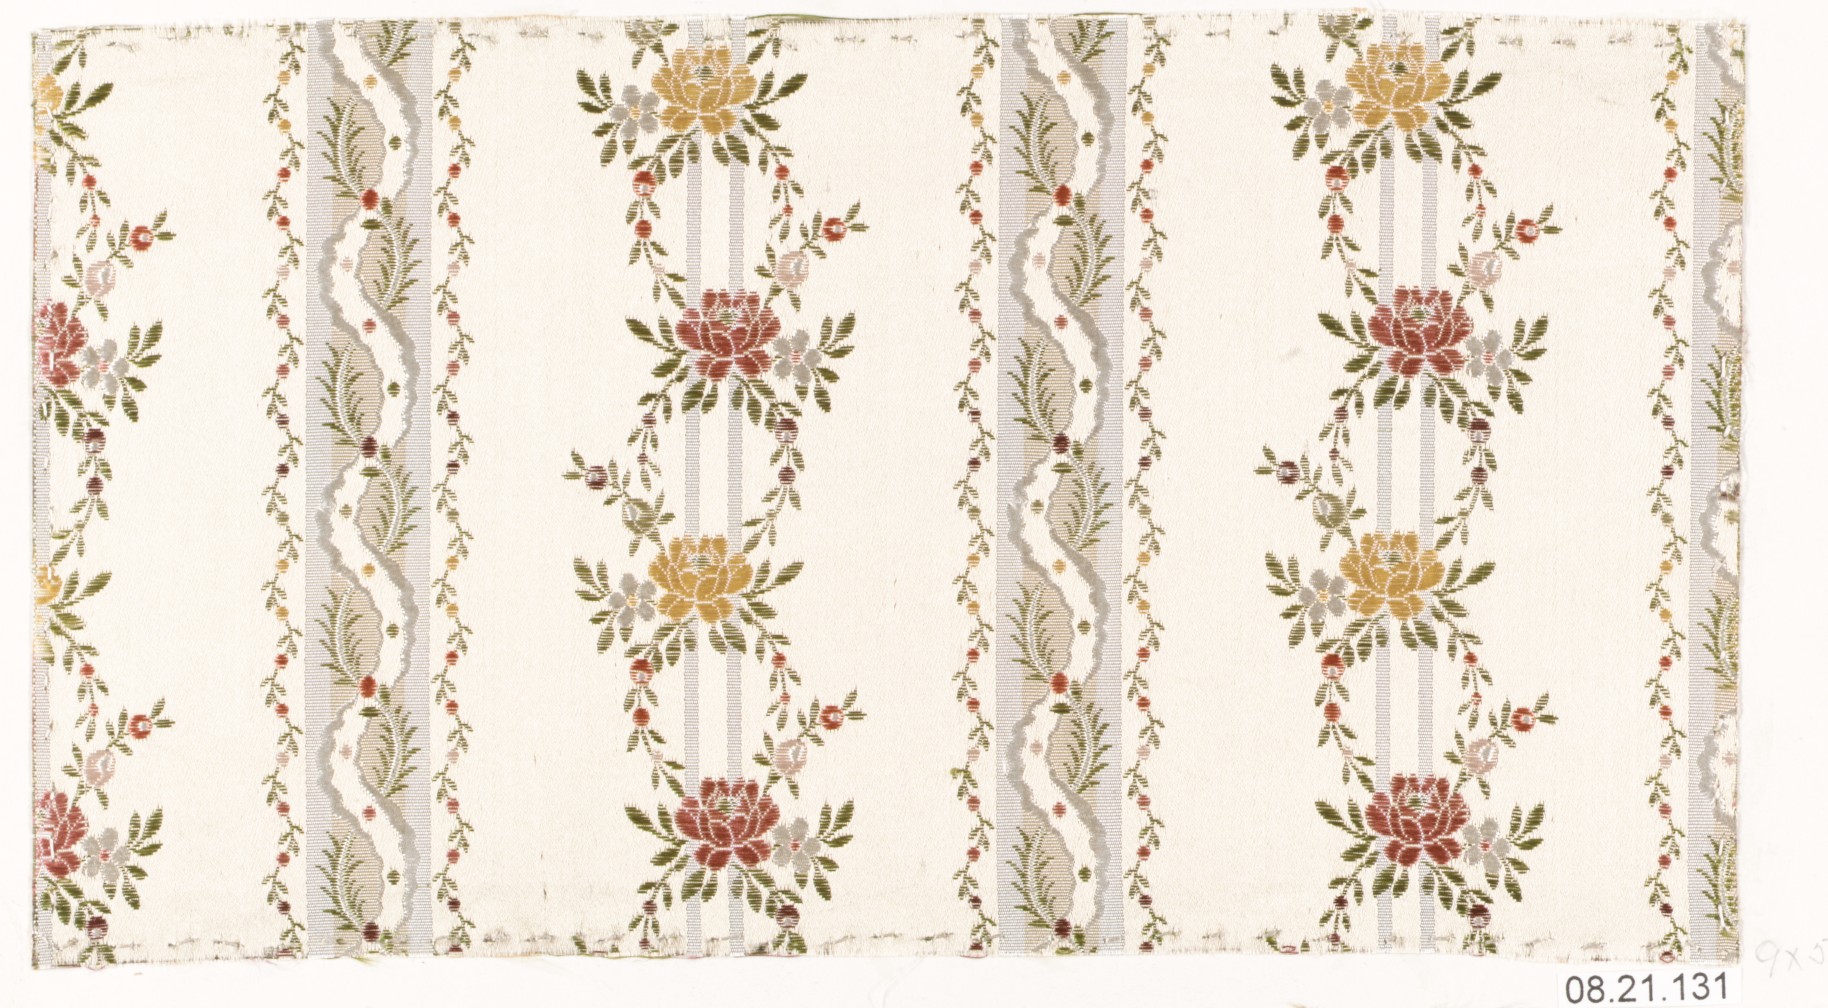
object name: textile sample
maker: Anonymous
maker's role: designer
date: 1900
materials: silk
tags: flowers